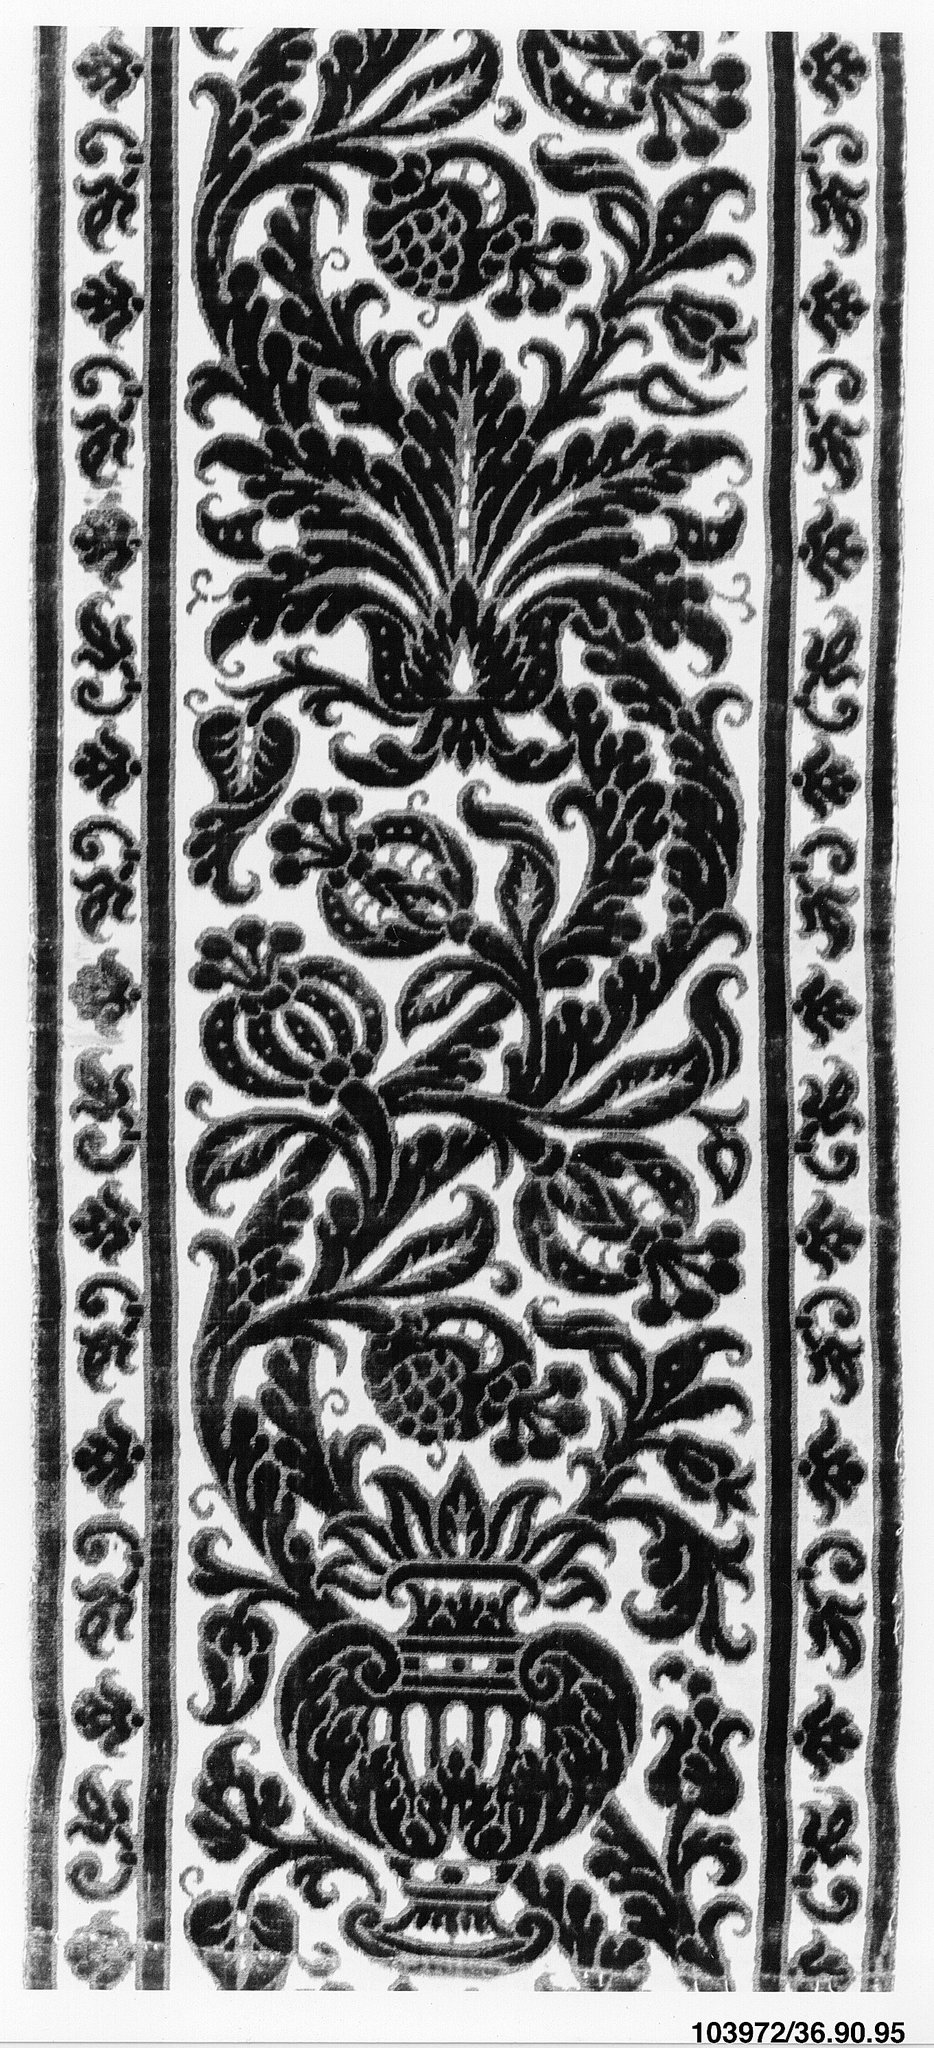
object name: border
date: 1601-1700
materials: silk